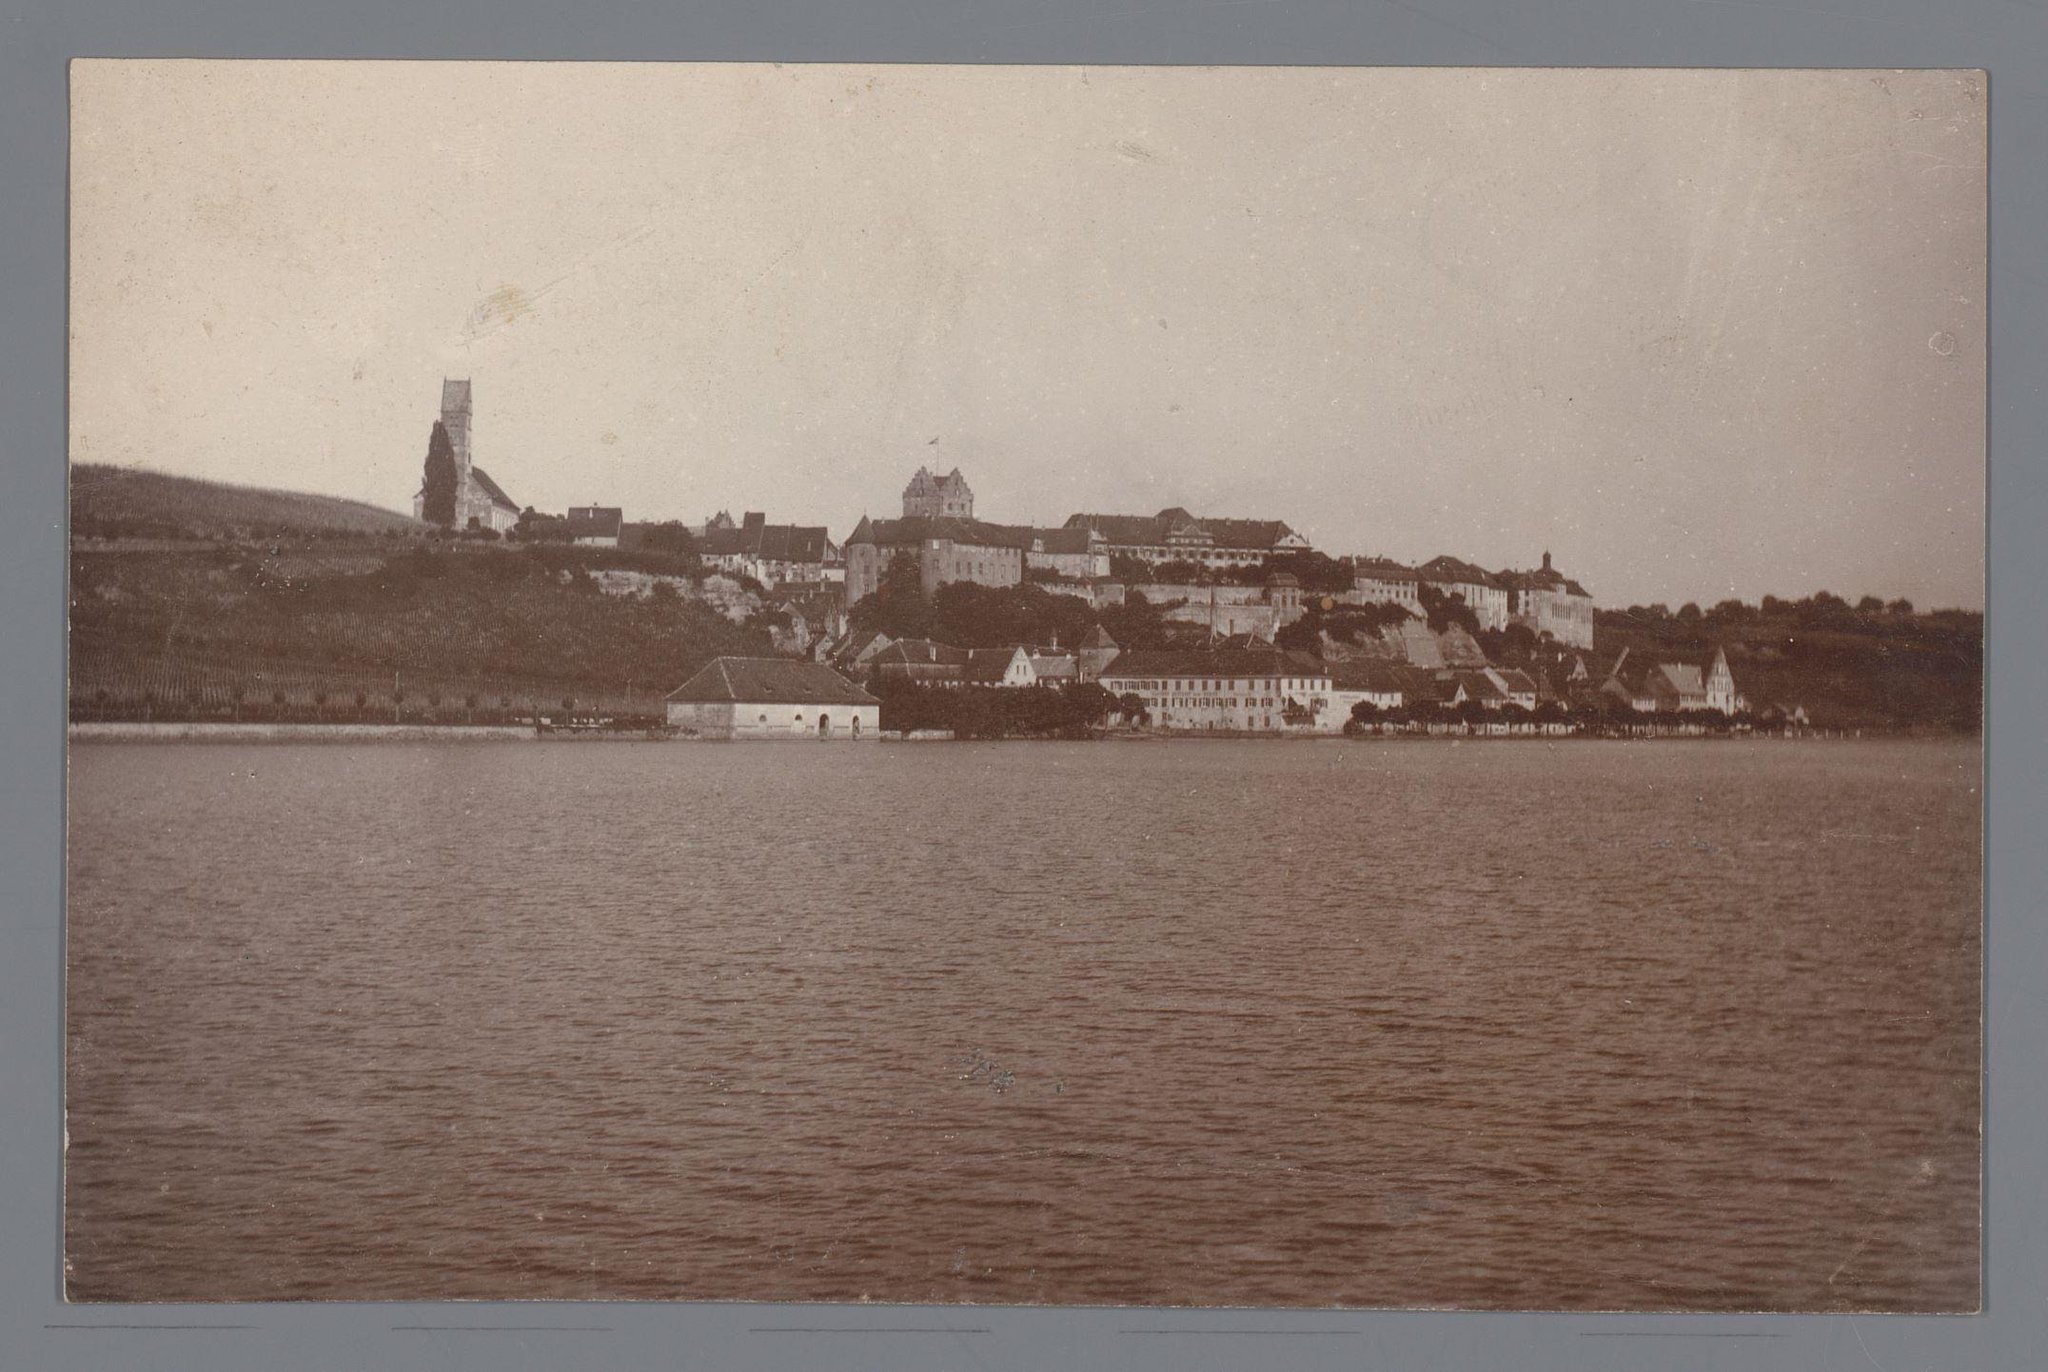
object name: photograph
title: Gezicht op Meersburg vanaf het Bodenmeer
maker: Anonymous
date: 1890-1930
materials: paper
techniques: gelatin silver print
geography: meersburg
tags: city-view in general; 'veduta'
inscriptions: number: ‘1967.’